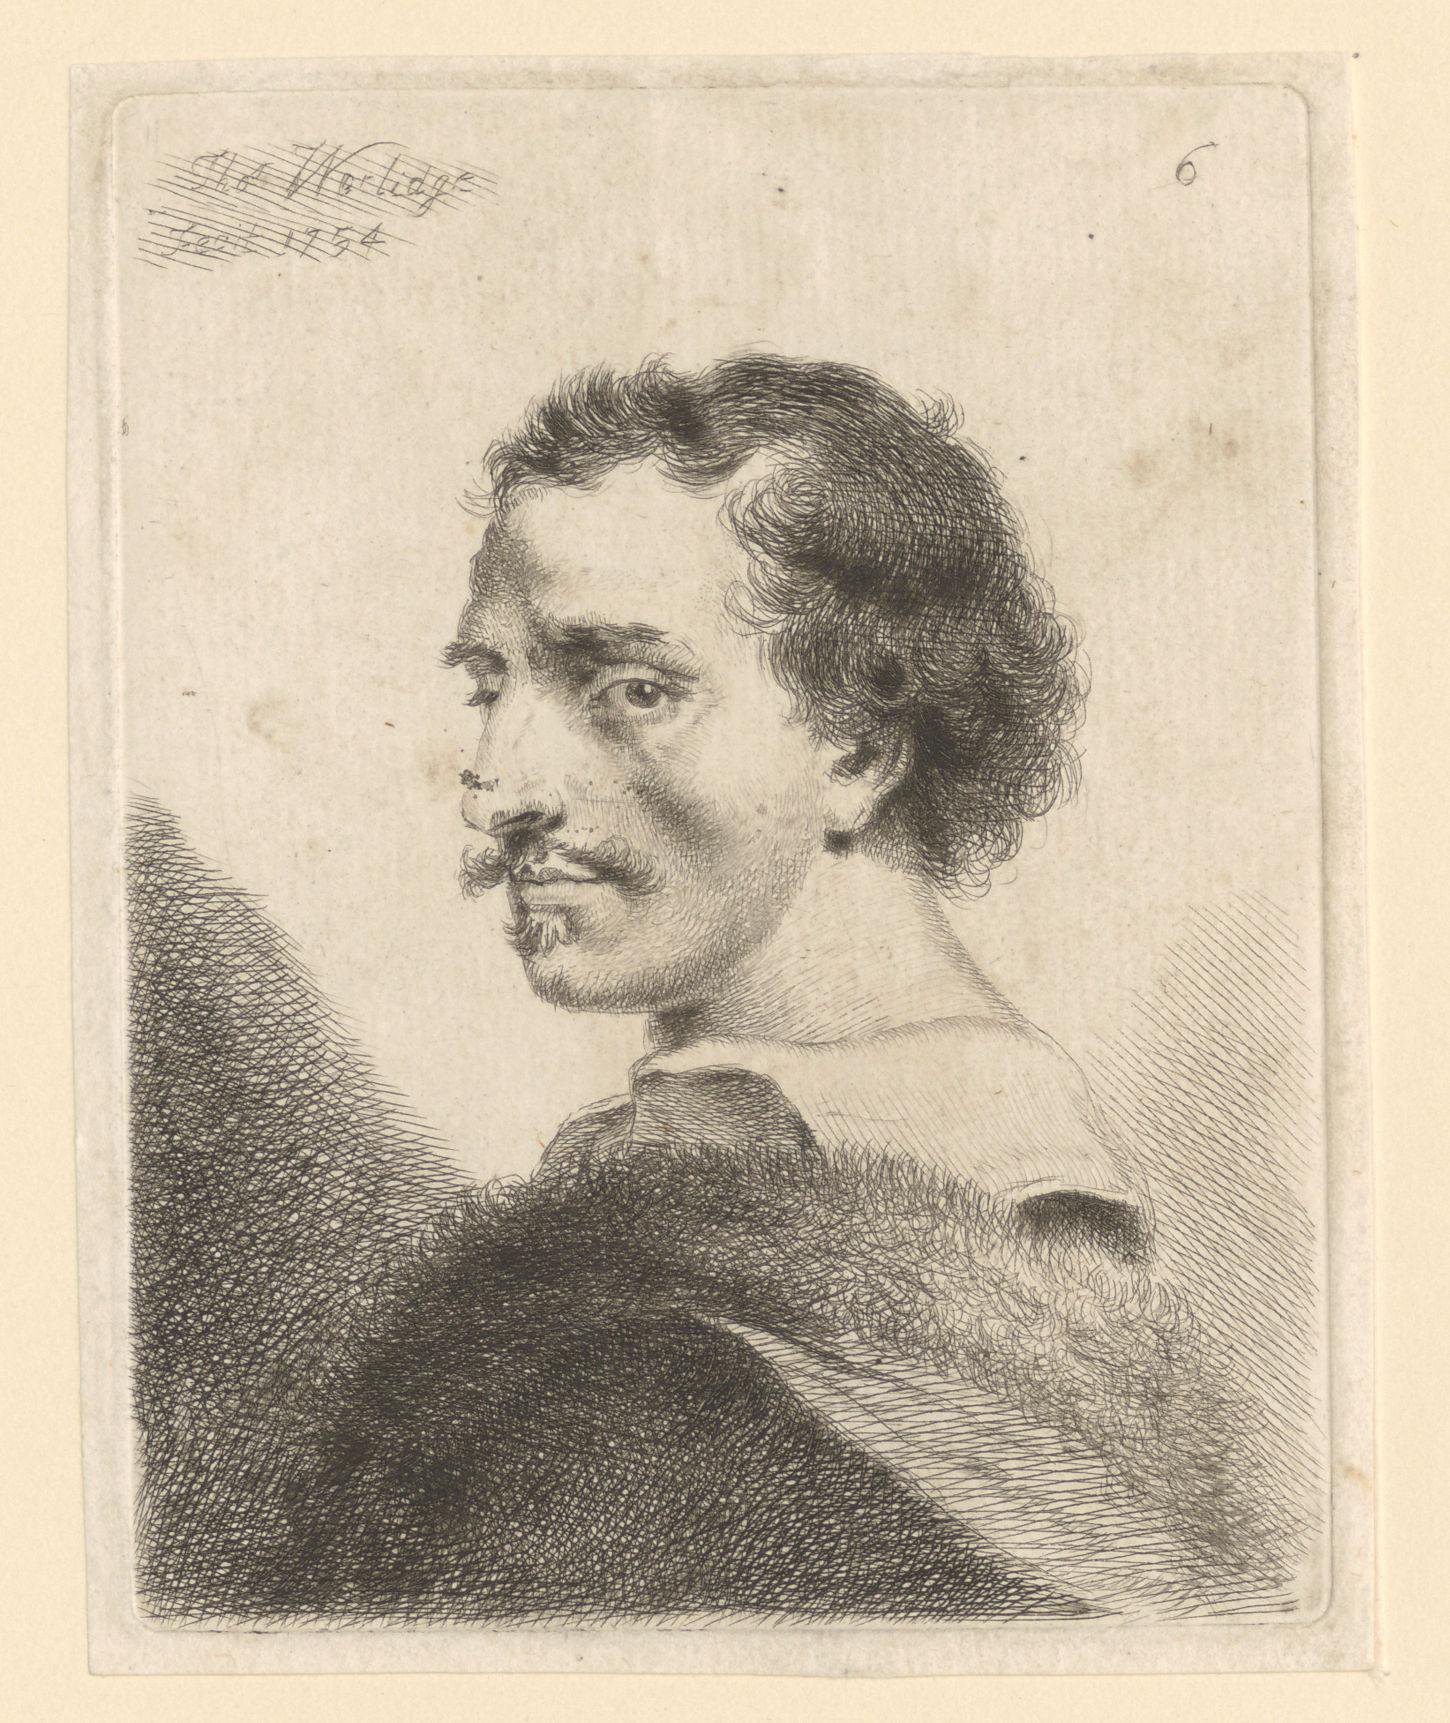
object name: print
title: Portret van onbekende man met snor en jas met bont, naar links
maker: thomas worlidge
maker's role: print maker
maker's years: 1700-1766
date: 1754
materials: paper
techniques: drypoint, etching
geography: london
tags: anonymous historical person portrayed alone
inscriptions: collector's mark: Lugt 2228, collector's mark: Lugt 2760